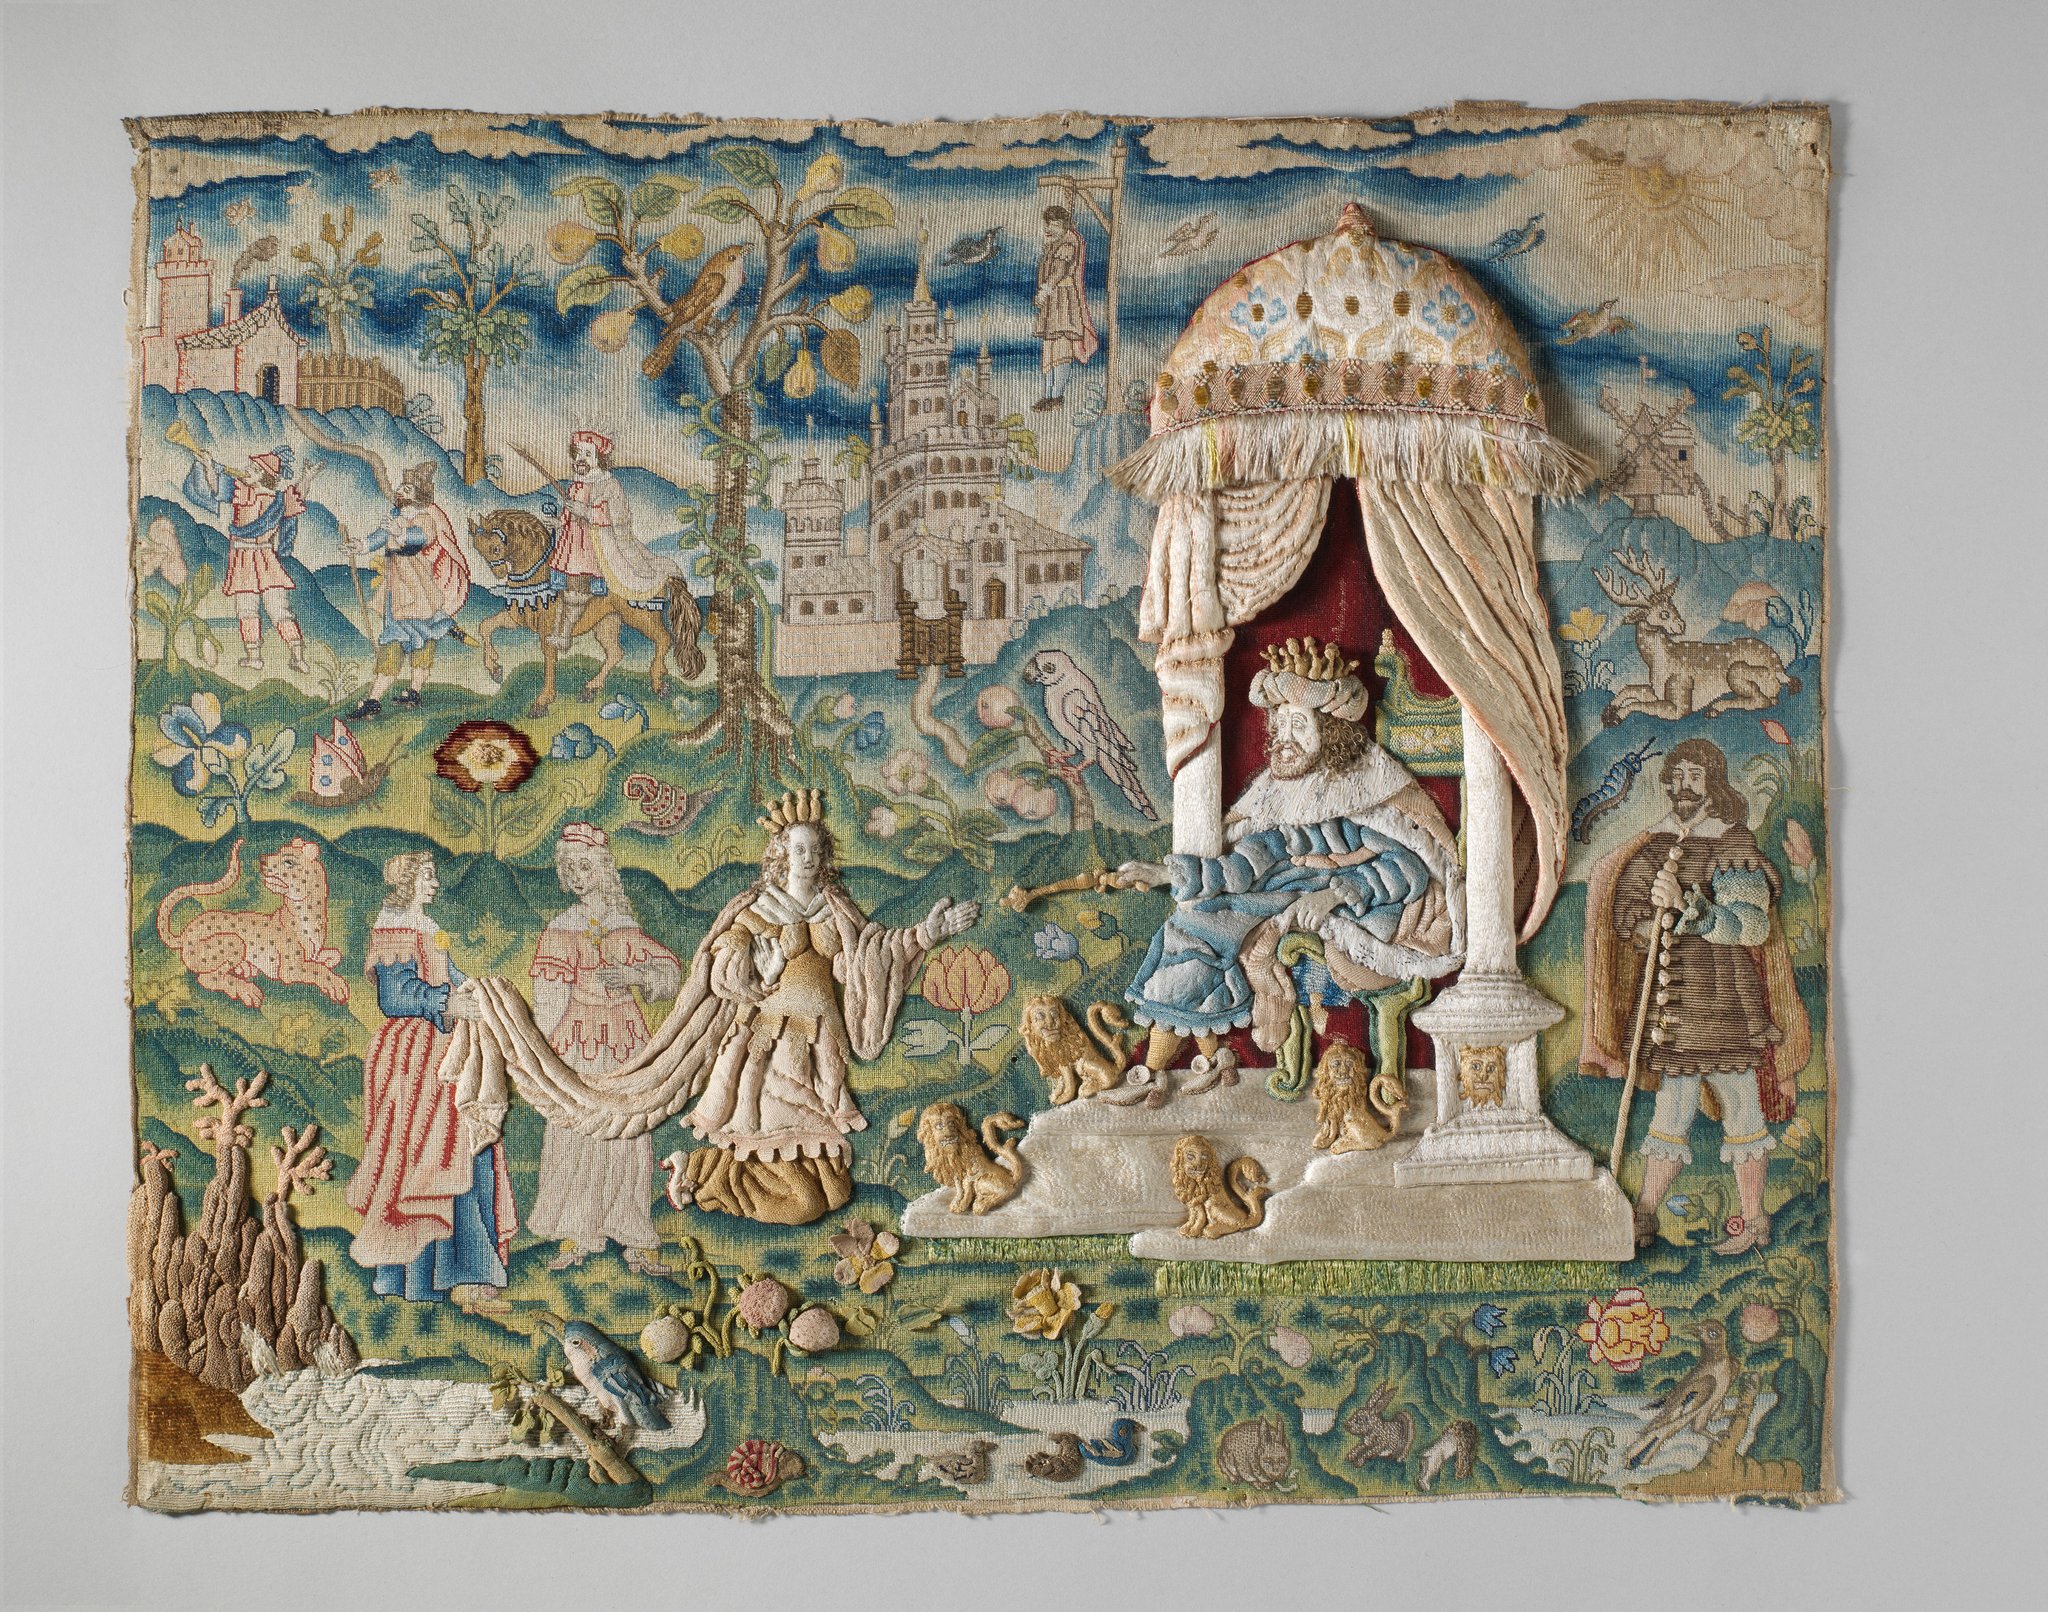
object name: embroidered picture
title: Esther and Ahasuerus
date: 1634-1666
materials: canvas, textile, thread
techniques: stitching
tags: birds,kings,men,women,deer,horses,lions,esther,ahasuerus